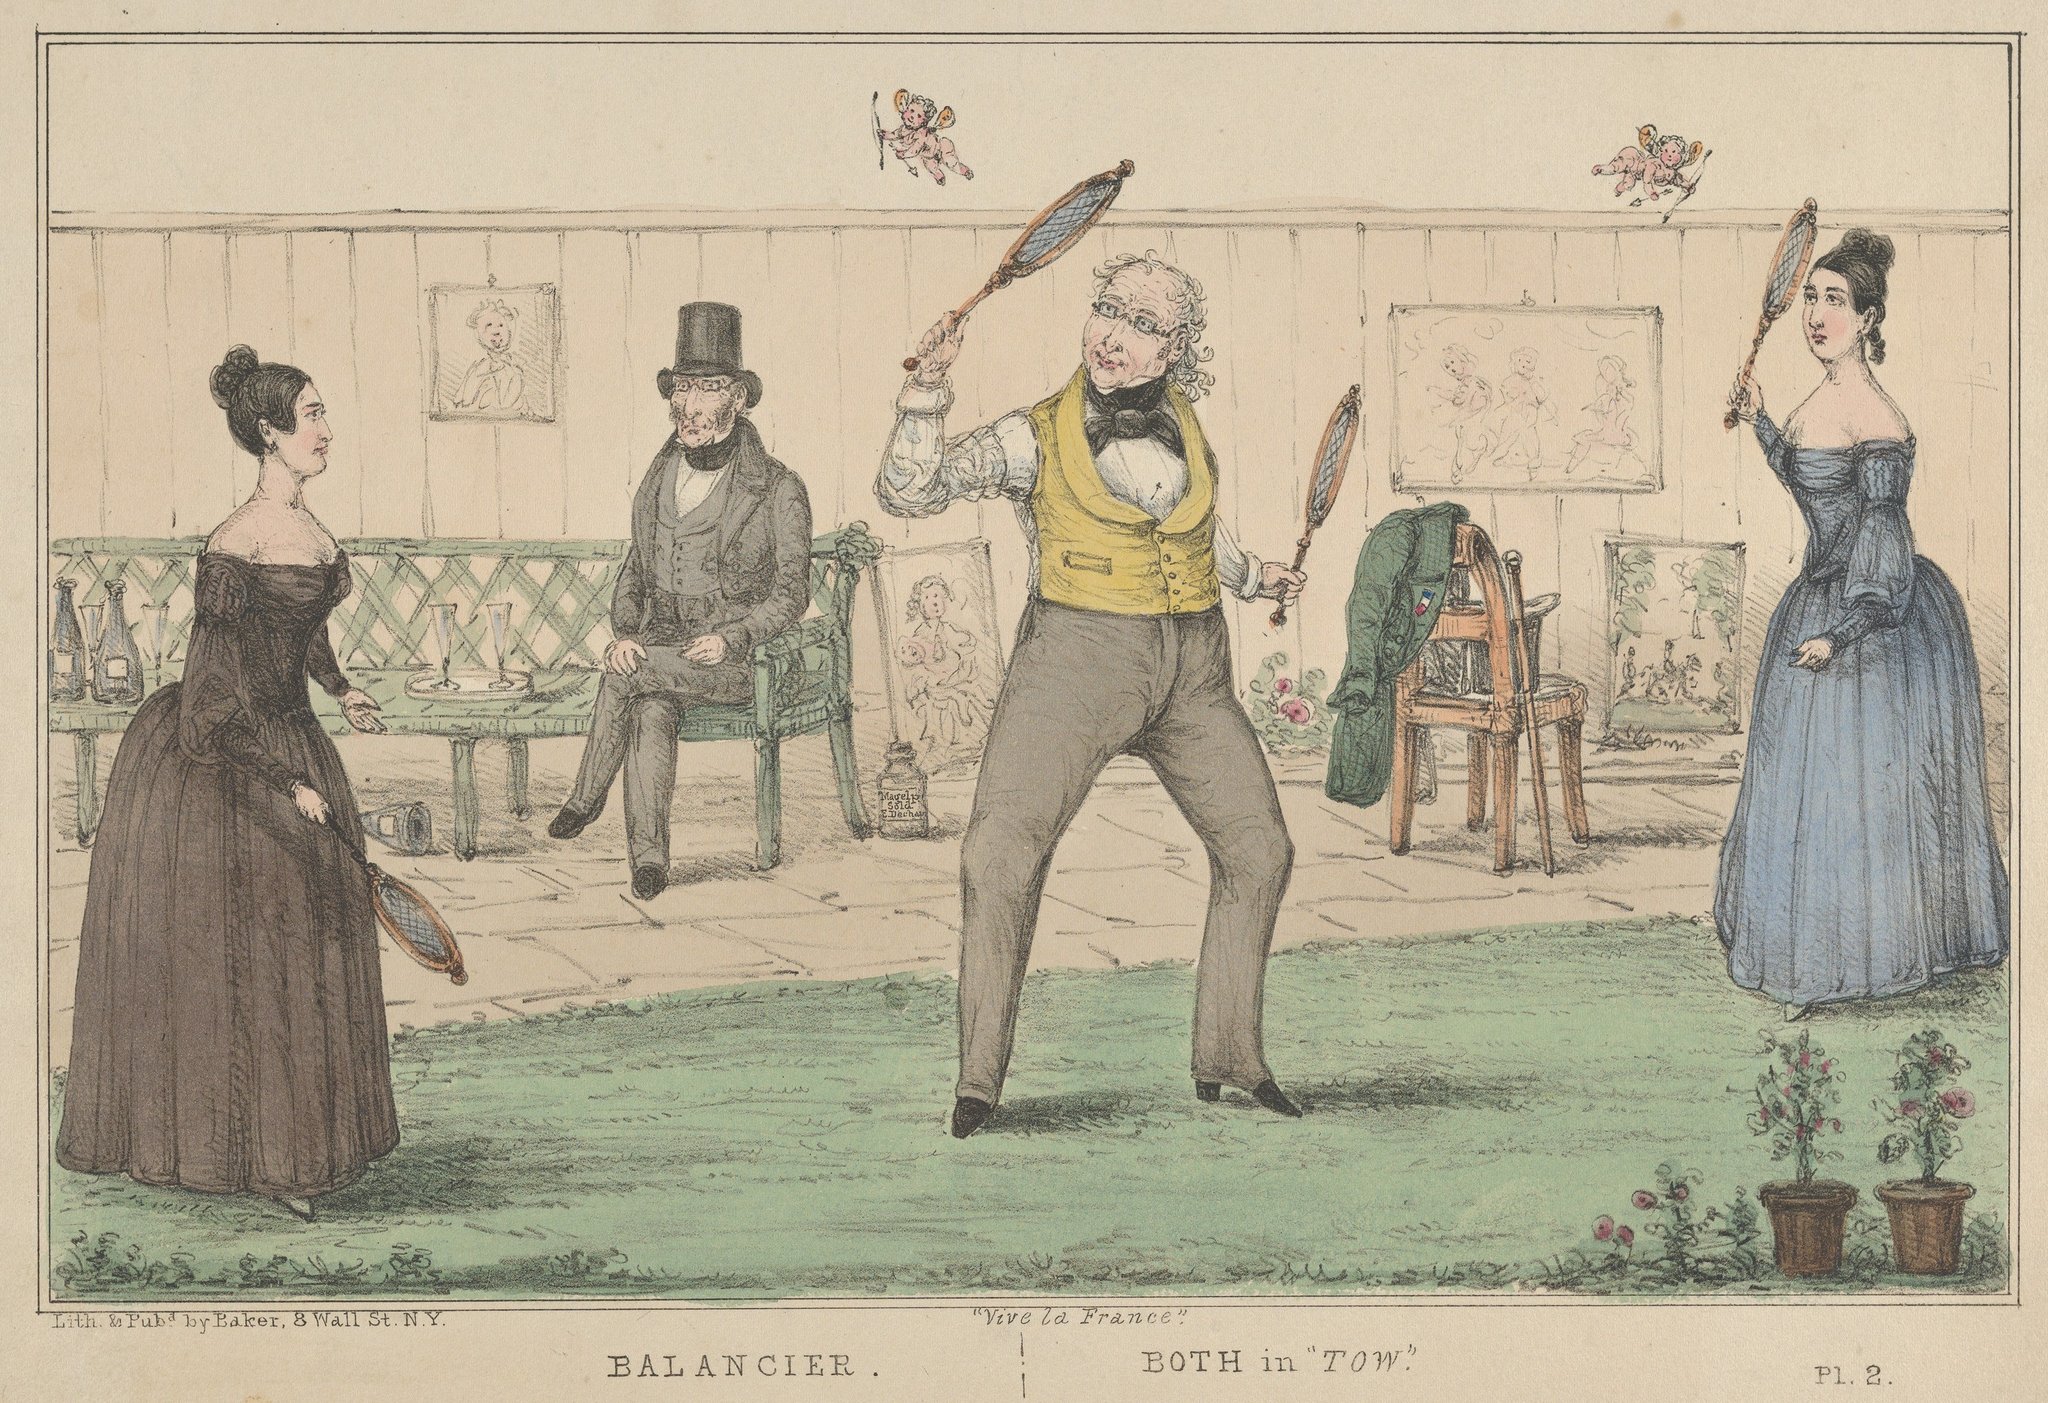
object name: print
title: Vive la France, Balancier, Both in "Tow"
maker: alfred e. baker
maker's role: publisher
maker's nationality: american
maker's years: 1833-1842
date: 1840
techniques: hand coloring, lithograph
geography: new york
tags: men,women,cupid,games,caricature